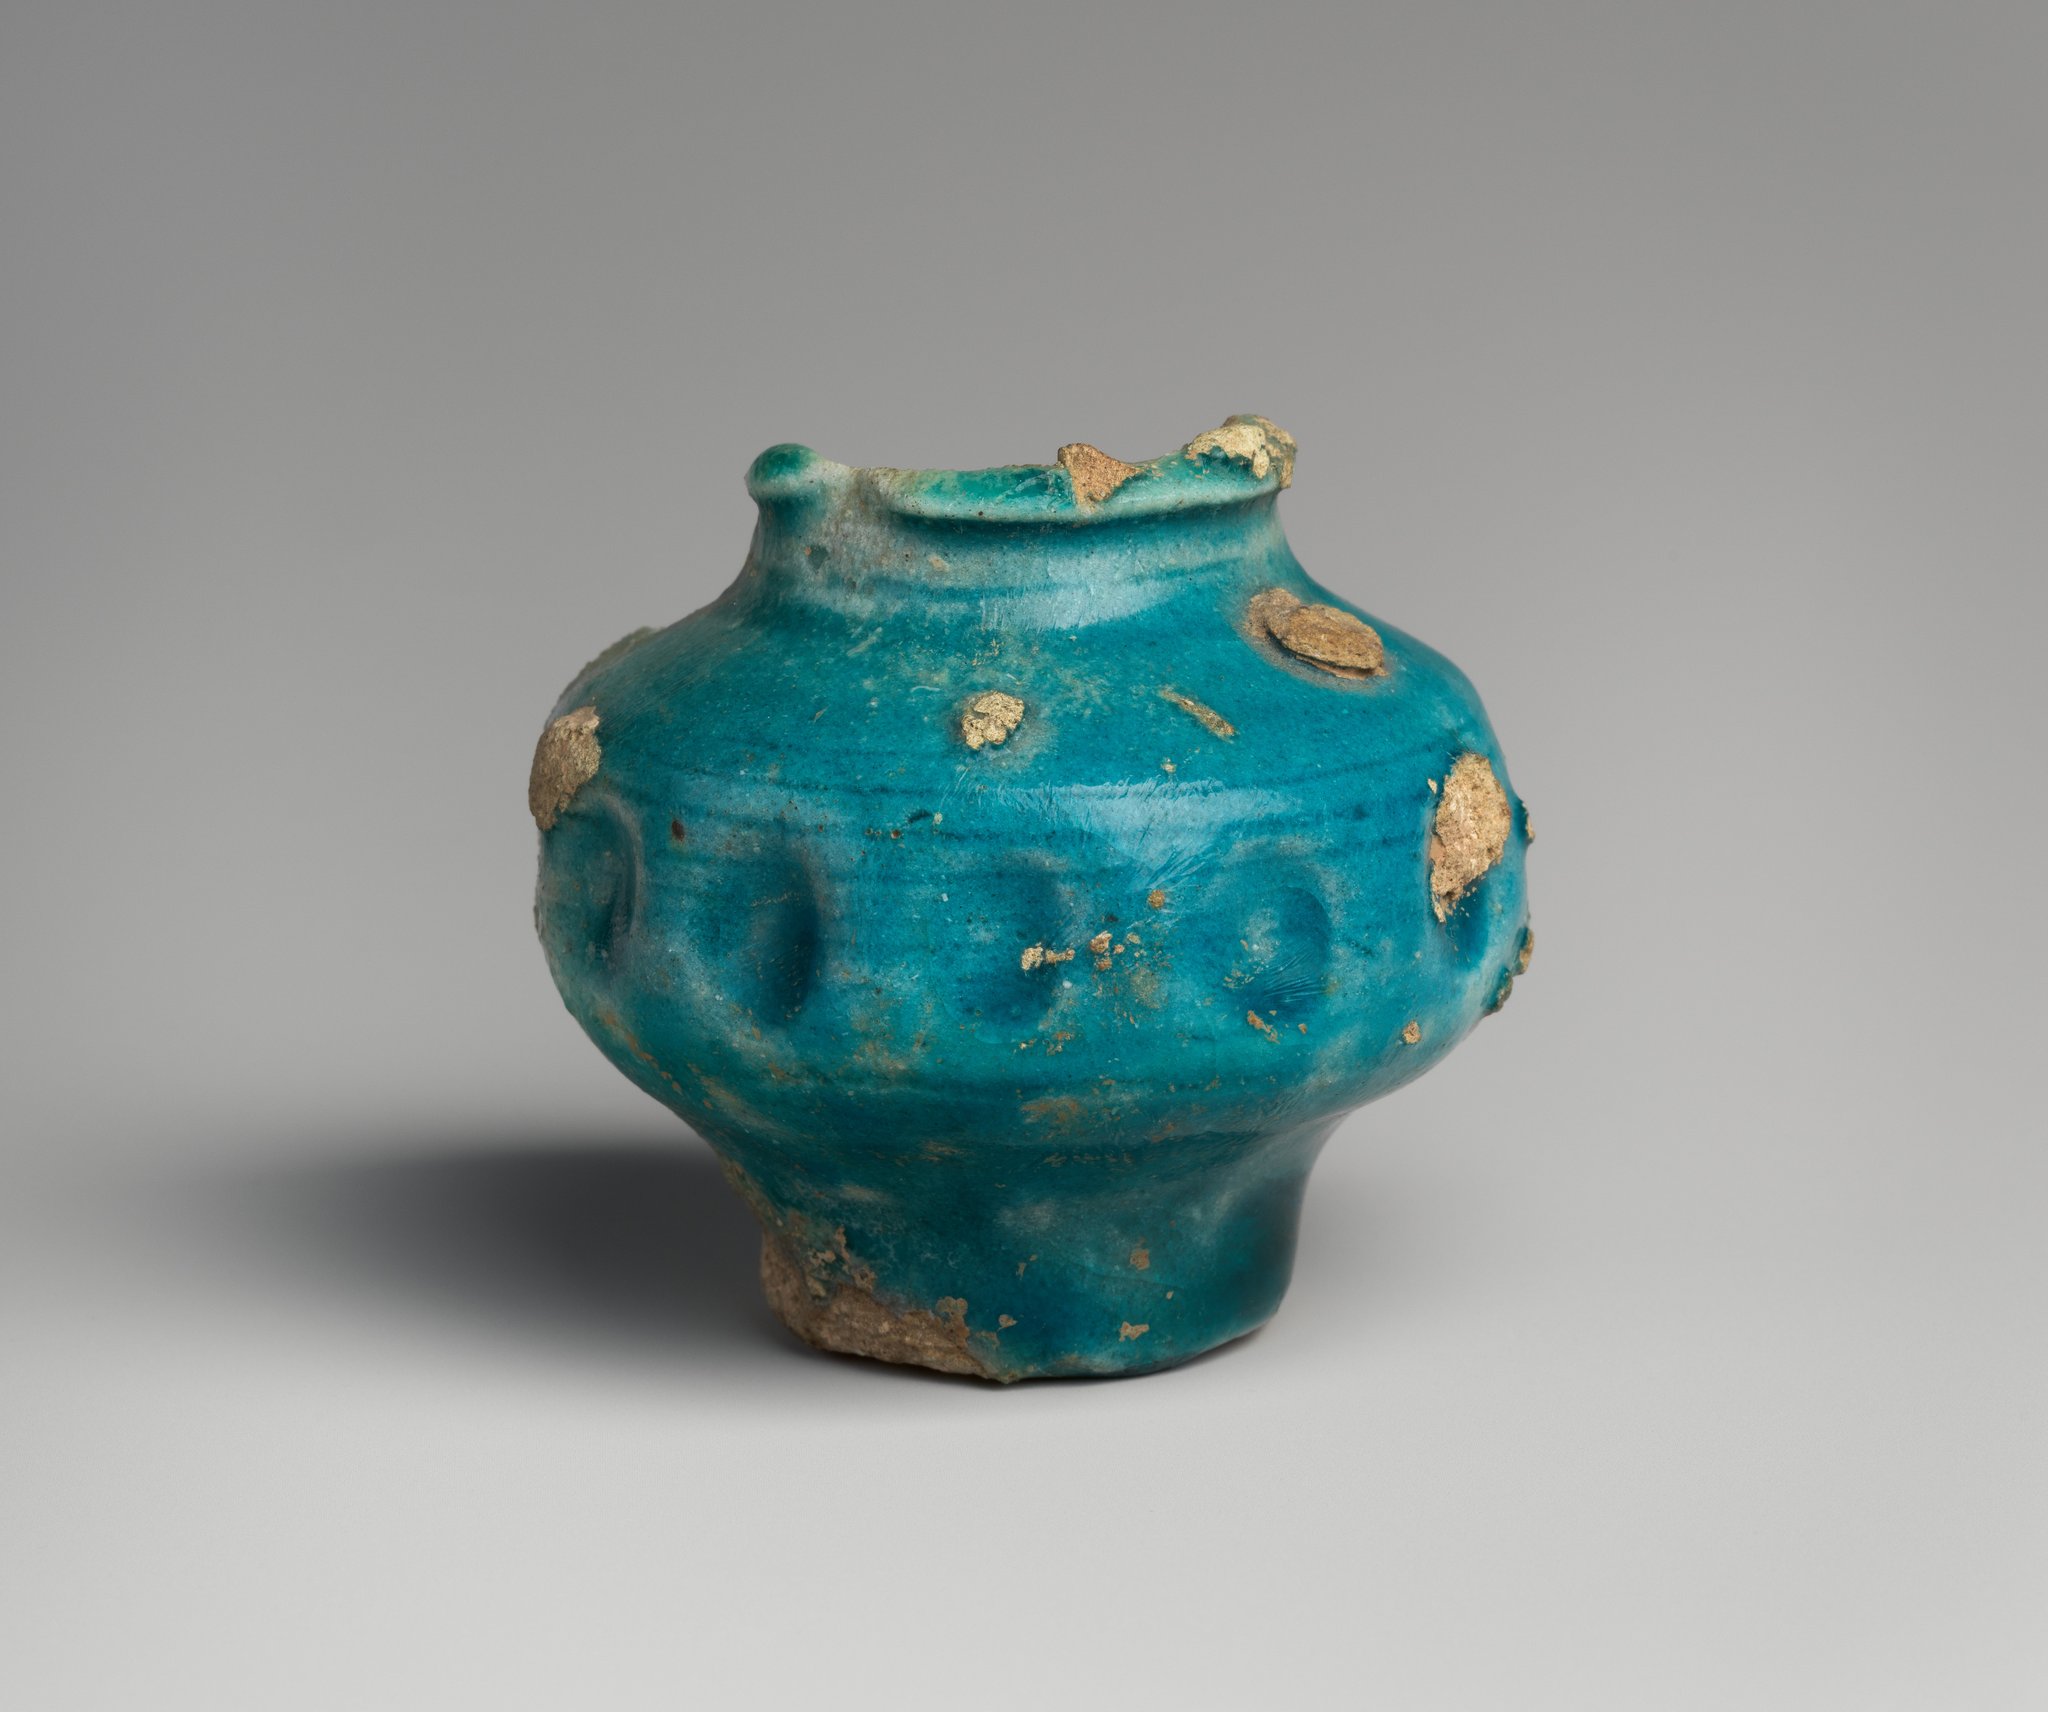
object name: vase fragment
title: Fragment of a Misfired Miniature Vase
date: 1001-1200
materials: stonepaste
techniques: glazing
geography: iran